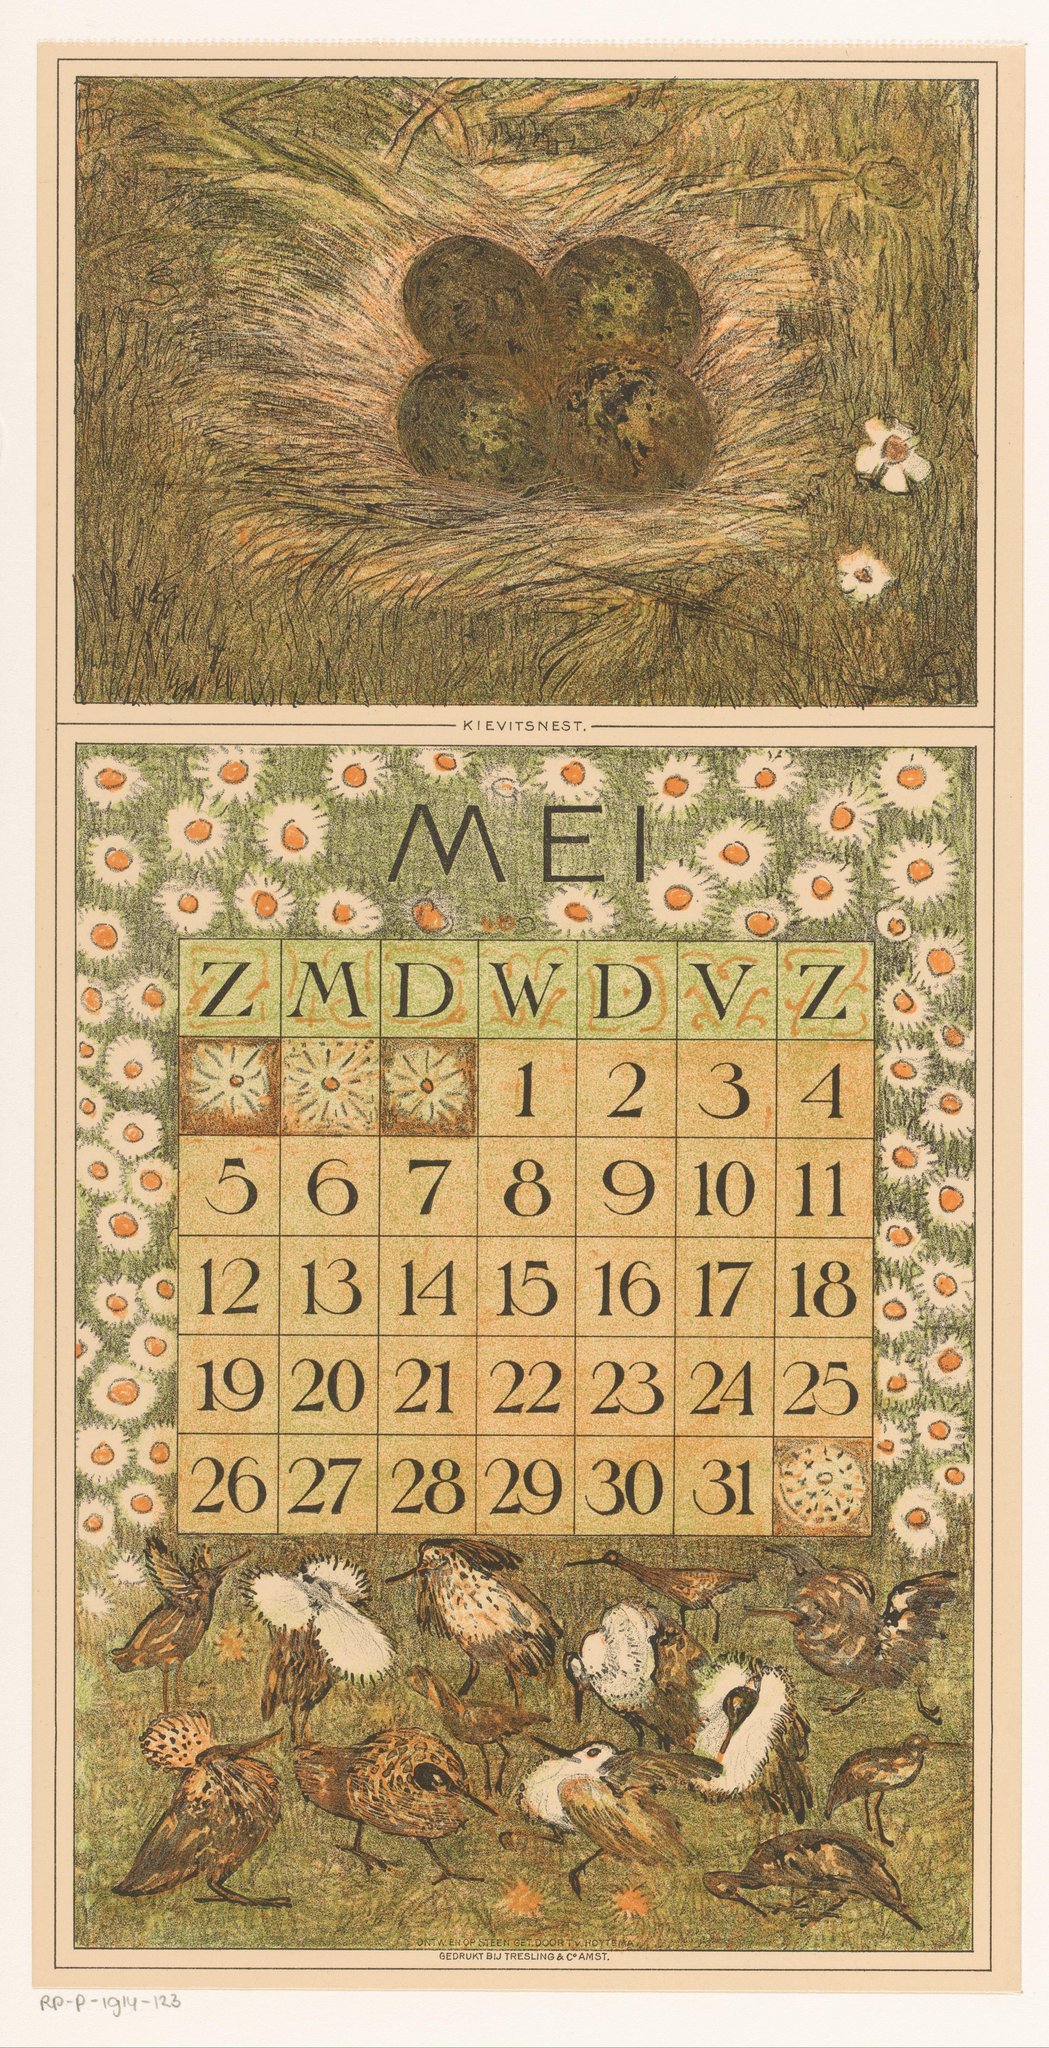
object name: print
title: Kalender 1912 12 lithografien door Th. v. Hoytema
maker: theo van hoytema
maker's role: draughtsman, painter, print maker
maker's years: 1863-1917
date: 1911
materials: paper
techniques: lithograph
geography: amsterdam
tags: flowers: daisy, shore-birds and wading-birds: lapwing, eggs, egg-dishes, may ~ other concepts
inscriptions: collector's mark: Lugt 2228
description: Rondom het calendarium kieviten of kemphanen en madeliefjes. Bovenaan het blad een scheurlijn.